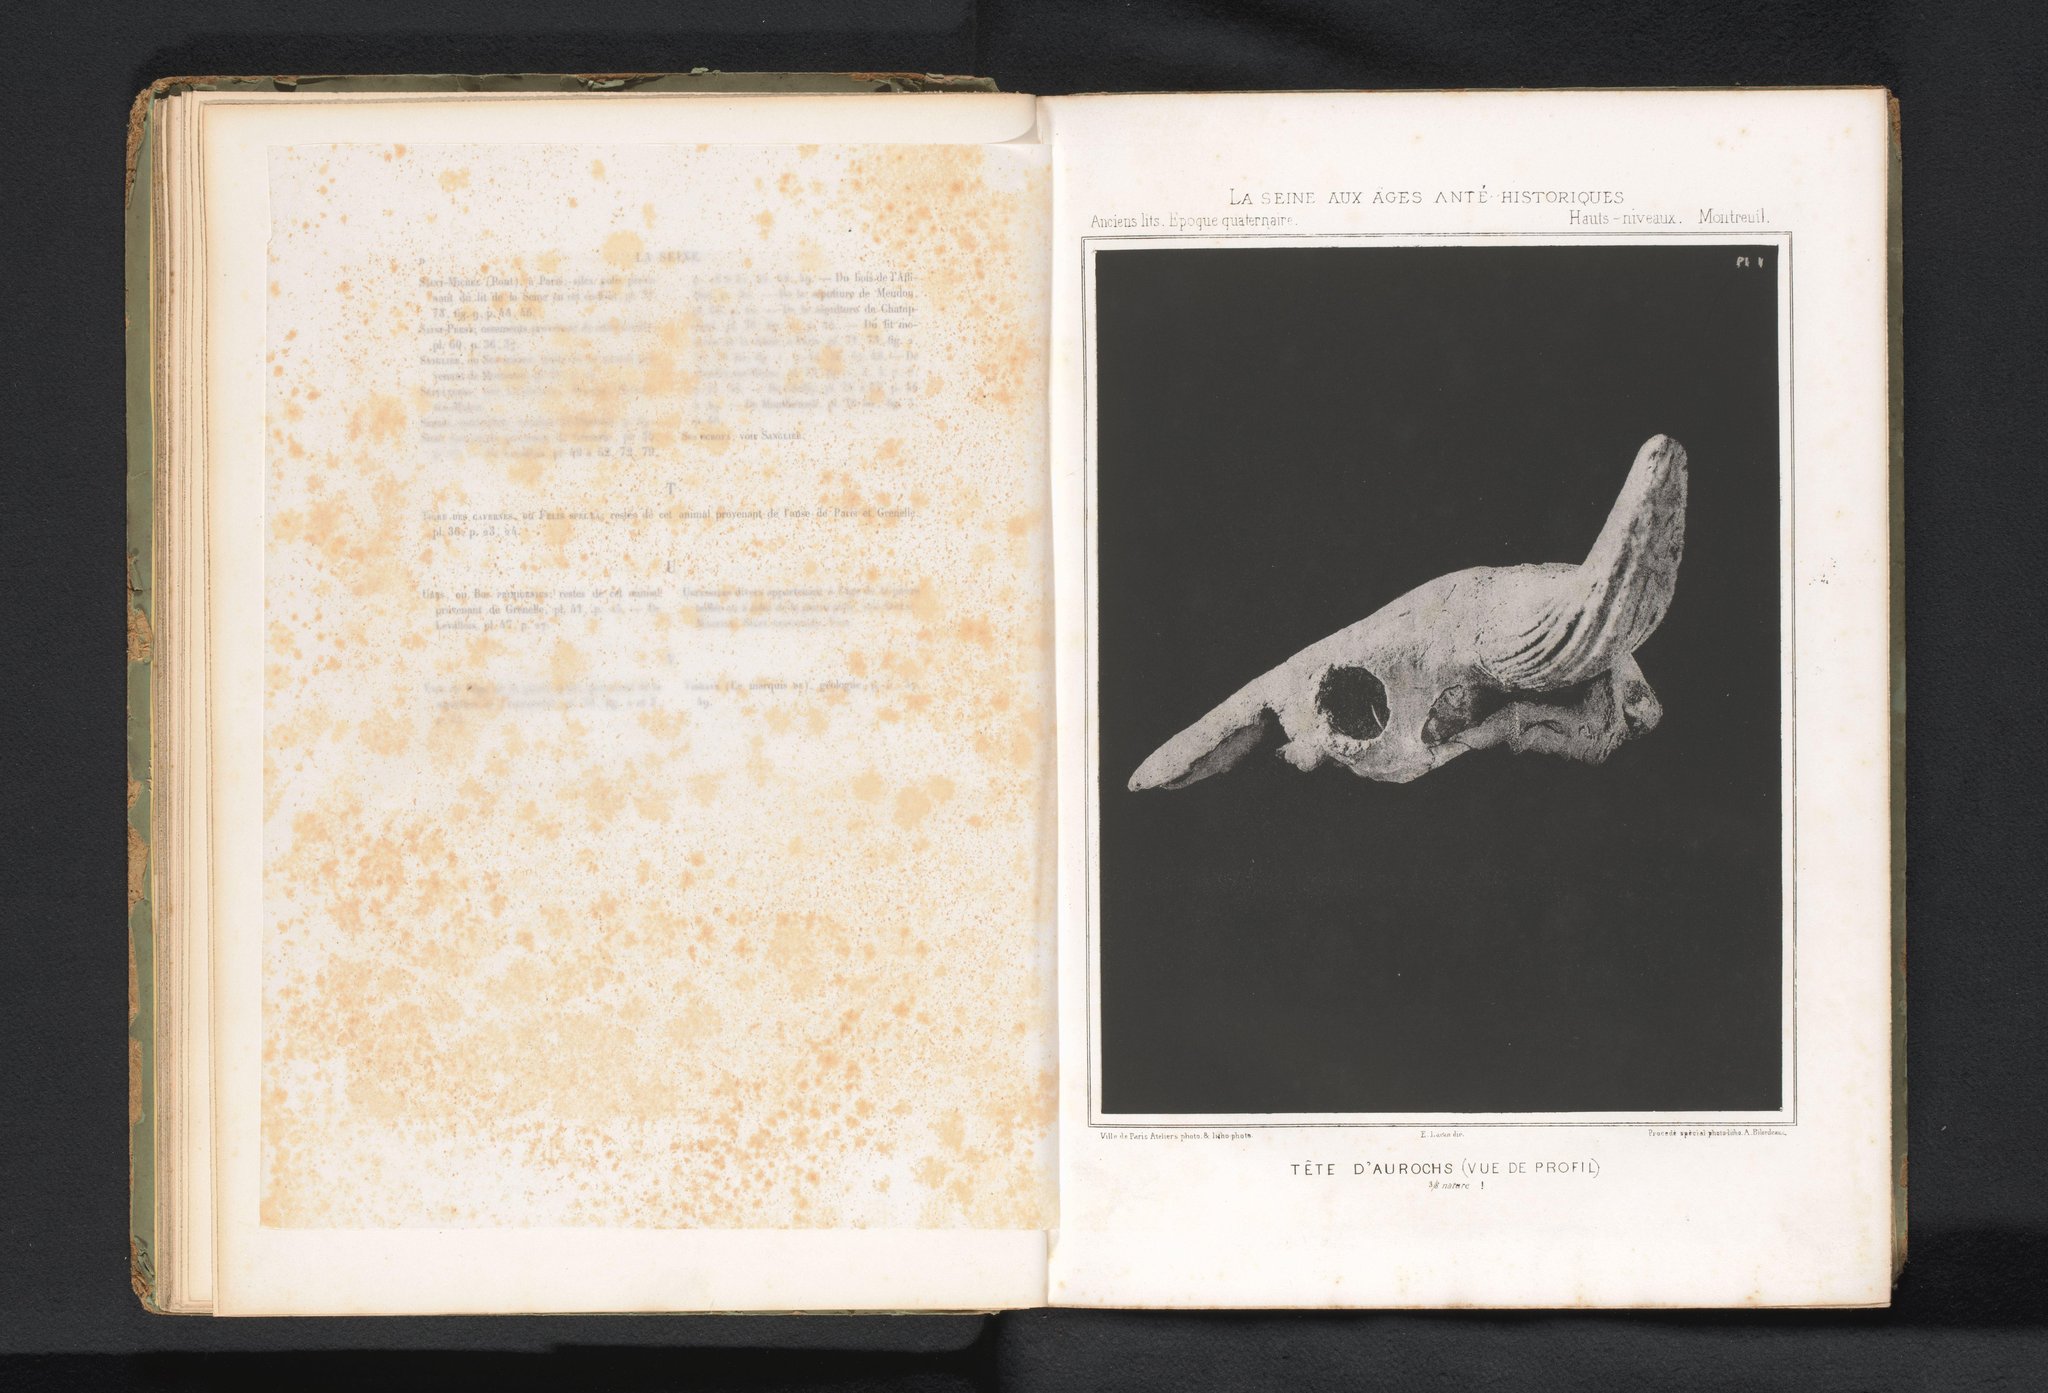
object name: photomechanical print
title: Schedel van een oeros, en profil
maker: ernest lacan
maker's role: fotograaf, redacteur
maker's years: 1829-1879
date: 1864-1869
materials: paper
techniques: photolithography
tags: animals (+ skeleton of an animal), palaeontology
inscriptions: inscription: ‘Procedé spécial photo-litho. A. Bilordeaux’, number: ‘Pl 1’, inscription: ‘3/8 nature !’